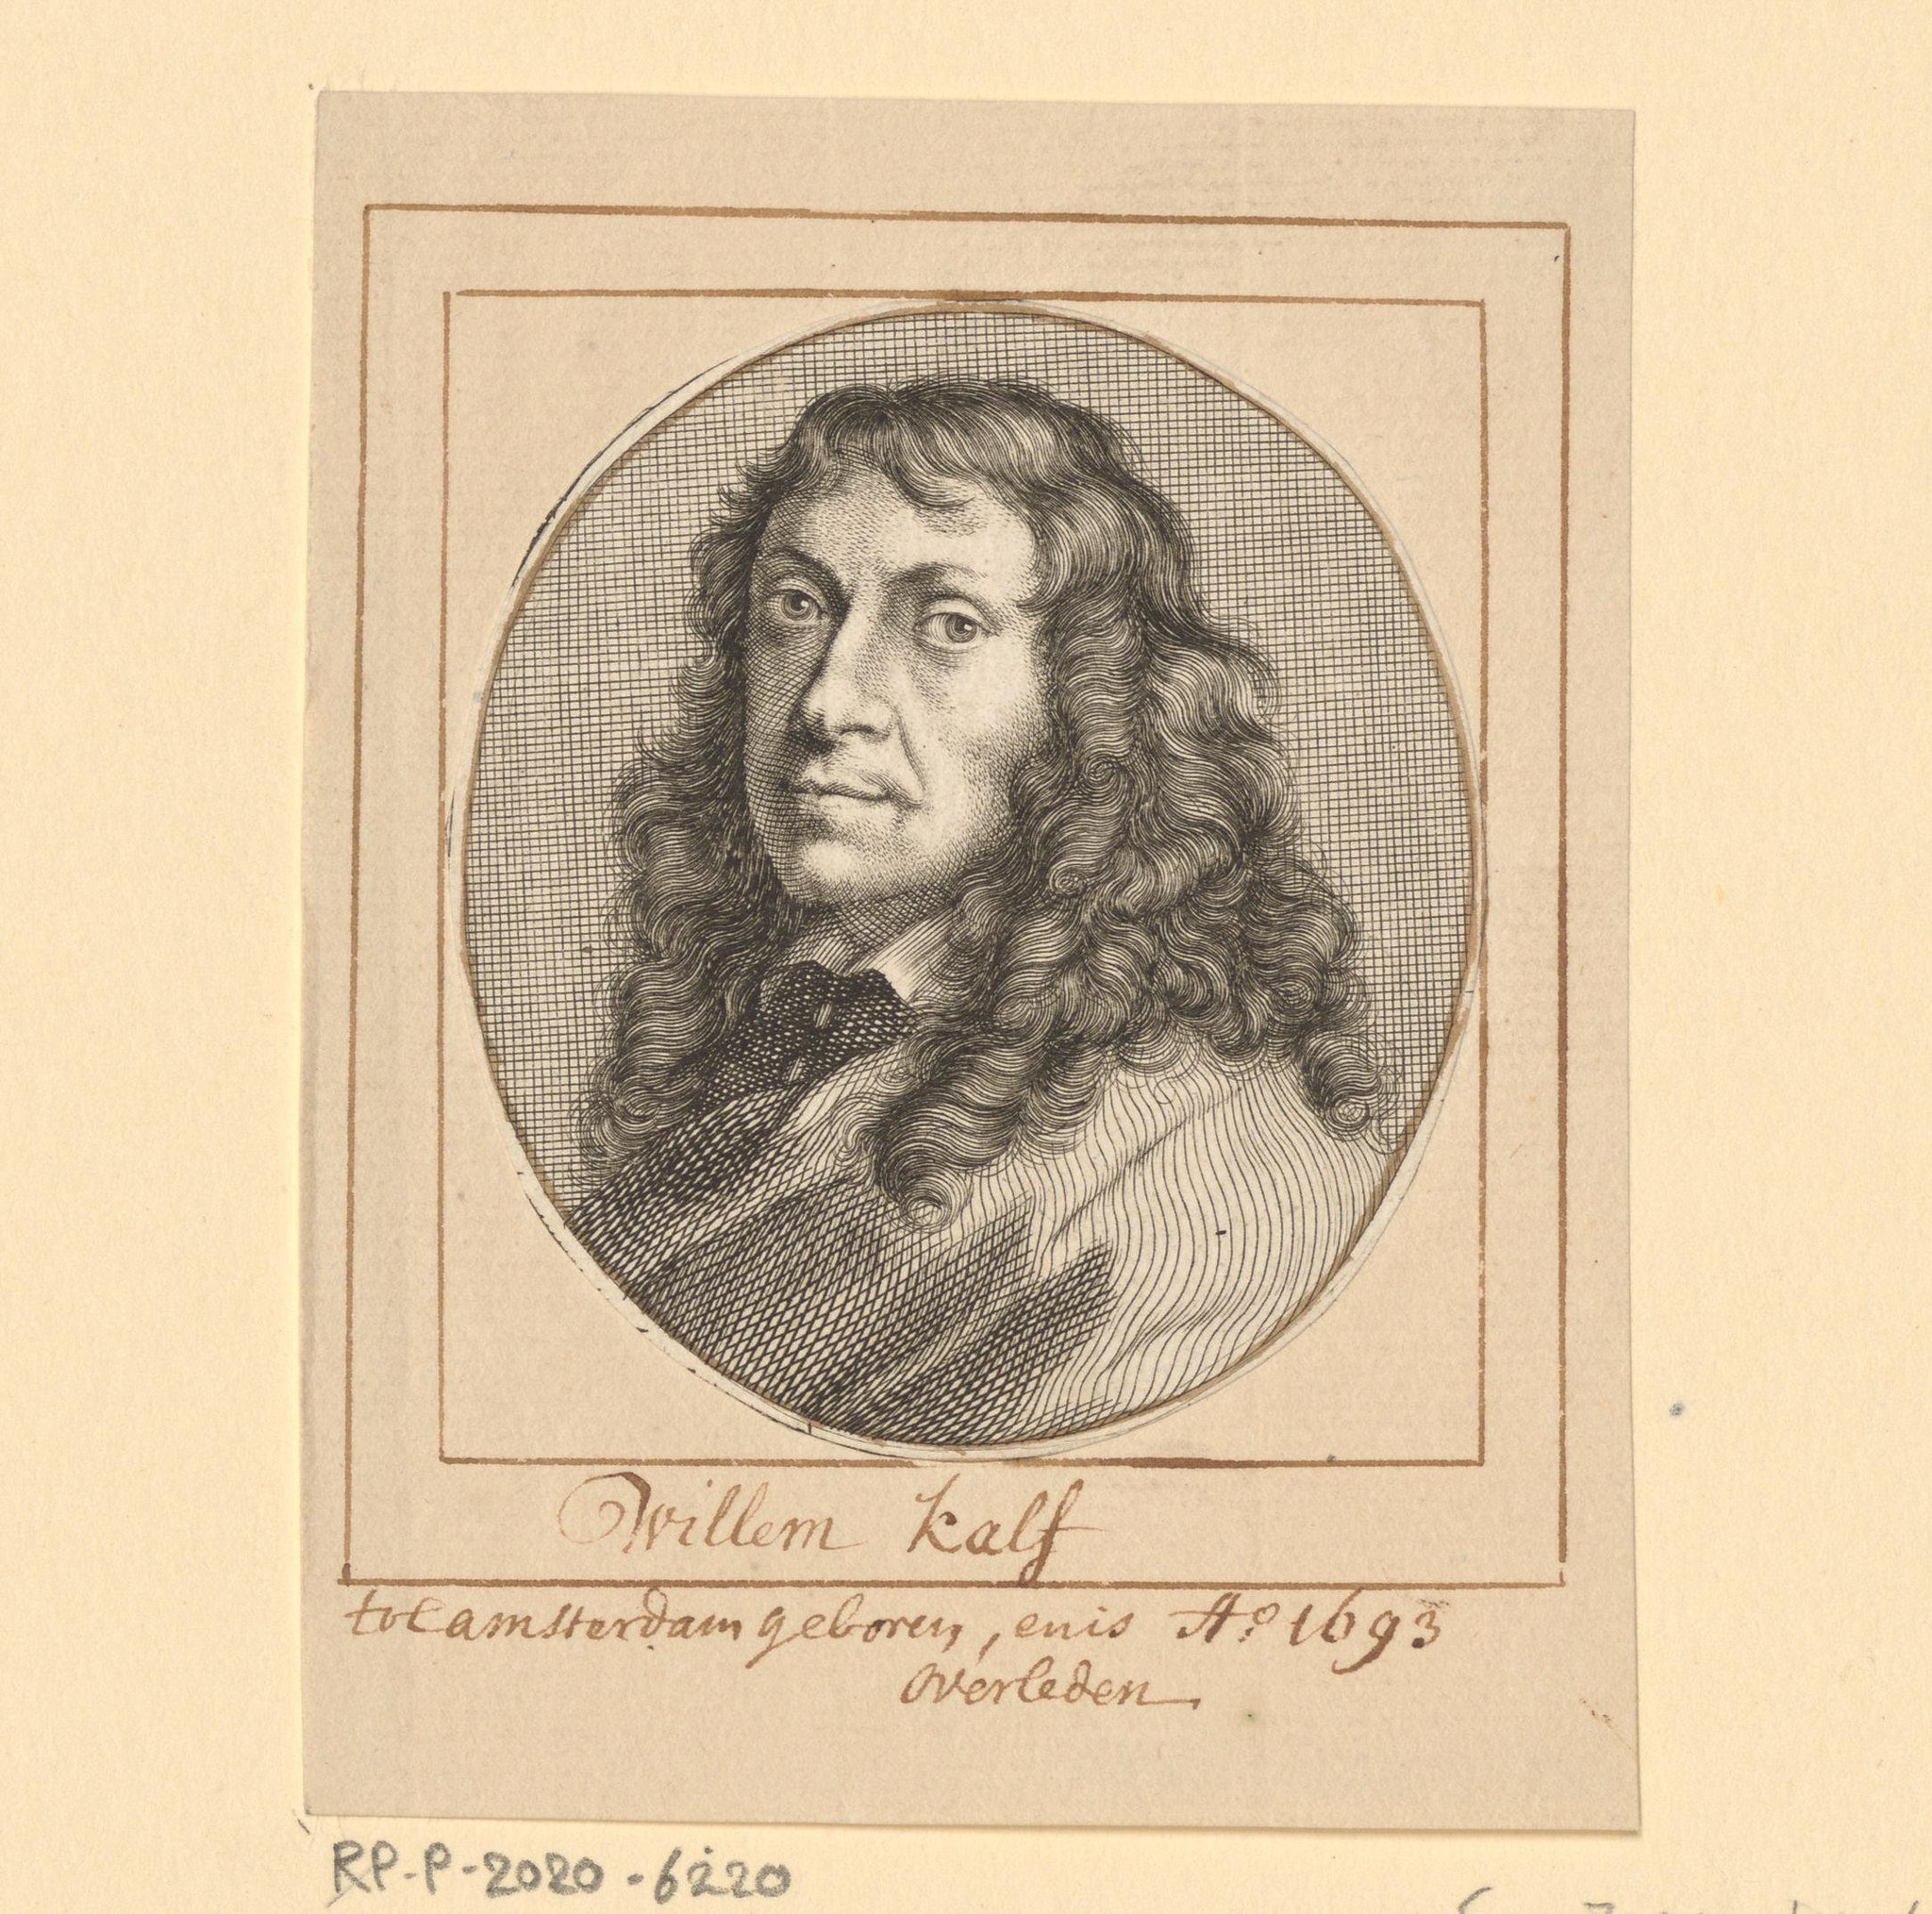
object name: print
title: Portret van Willem Kalf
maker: arnold houbraken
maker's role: draughtsman, painter, print maker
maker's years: 1660-1719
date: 1719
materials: paper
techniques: engraving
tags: rotterdam, willem kalf, historical persons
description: Prent mogelijk uit: Houbraken, Arnold. De groote schouburgh der Nederlantsche konstschilders en schilderessen (...). Amsterdam: Arnold Houbraken, 1719, dl. 2, tussen p. 196 en 197.